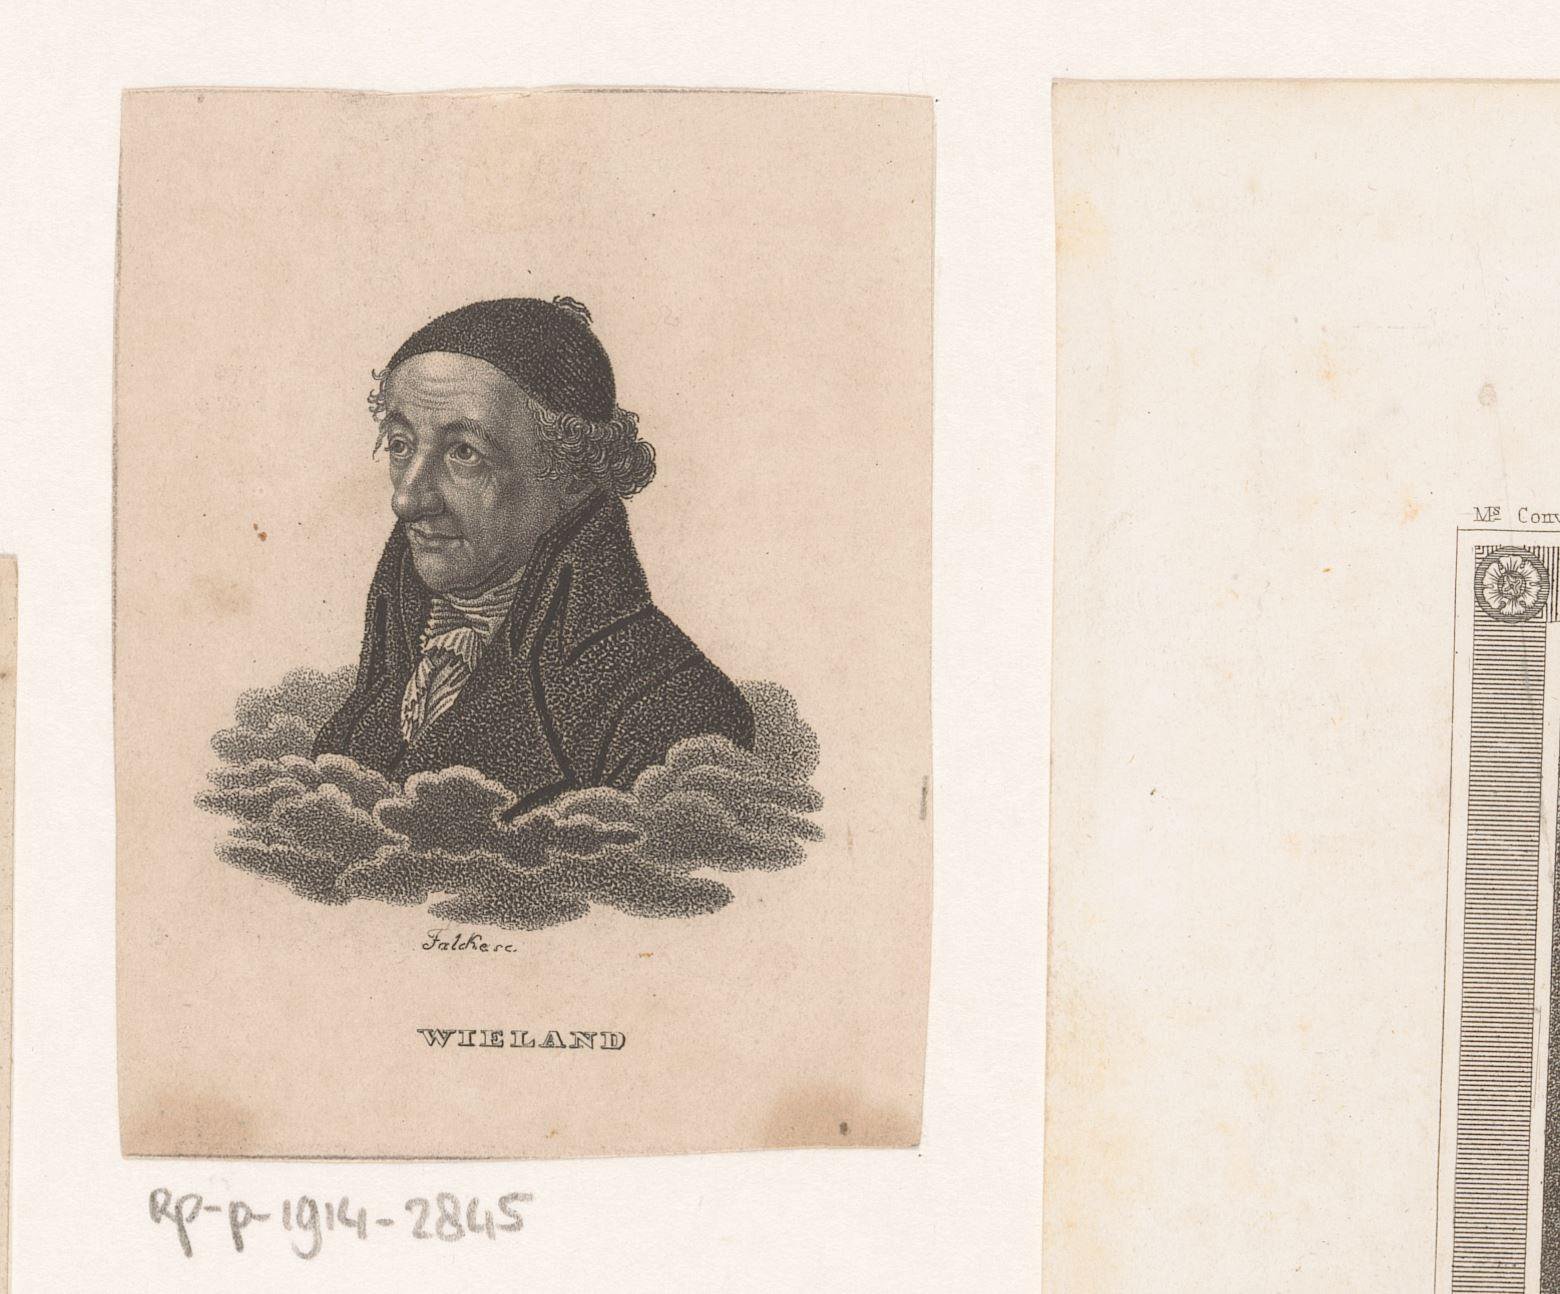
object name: print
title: Portret van Christoph Martin Wieland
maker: tobias falke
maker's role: print maker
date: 1813-1830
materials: paper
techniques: stippling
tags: publisher, christoph martin wieland, clouds, armorial bearing, heraldry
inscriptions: collector's mark: Lugt 2228